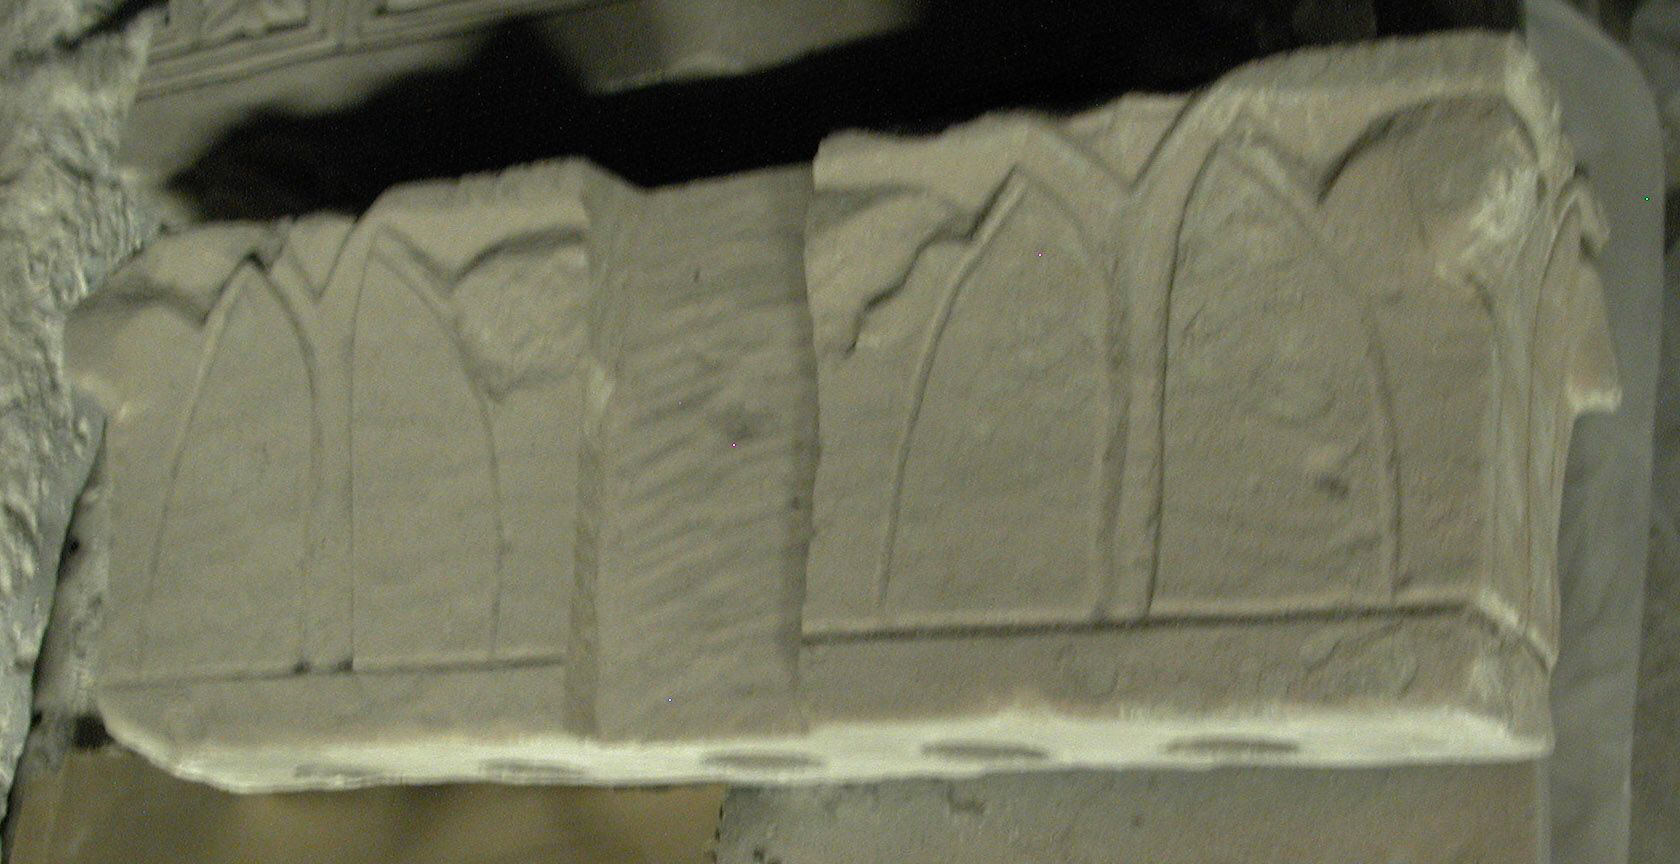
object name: capital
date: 501-700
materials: limestone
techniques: carving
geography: egypt